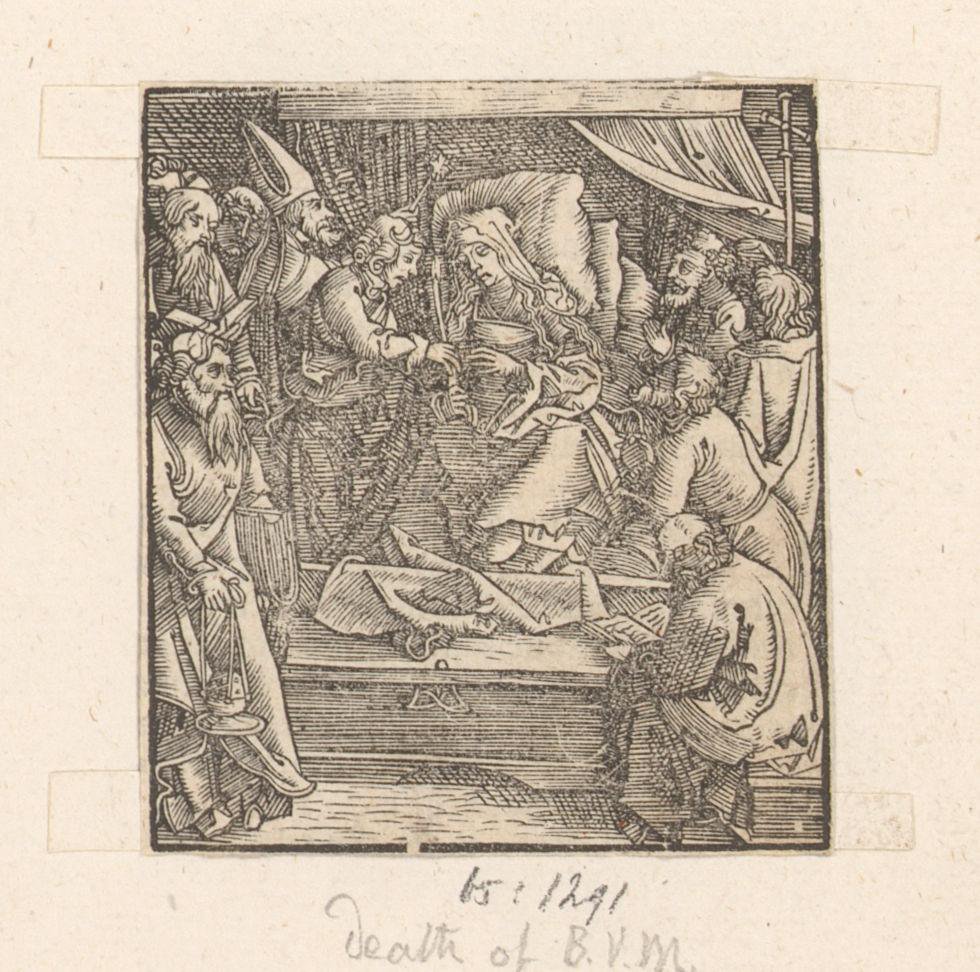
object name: book illustration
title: Sterfbed van Maria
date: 1515-1517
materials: paper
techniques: woodcut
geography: nuremberg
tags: the dormition: mary on her deathbed; the apostles are gathered around her (john the evangelist may be shown sleeping or dreaming)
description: Maria ligt op haar sterfbed. Rondom haar de apostelen die waken en bidden. Prent maakt deel uit van een album.